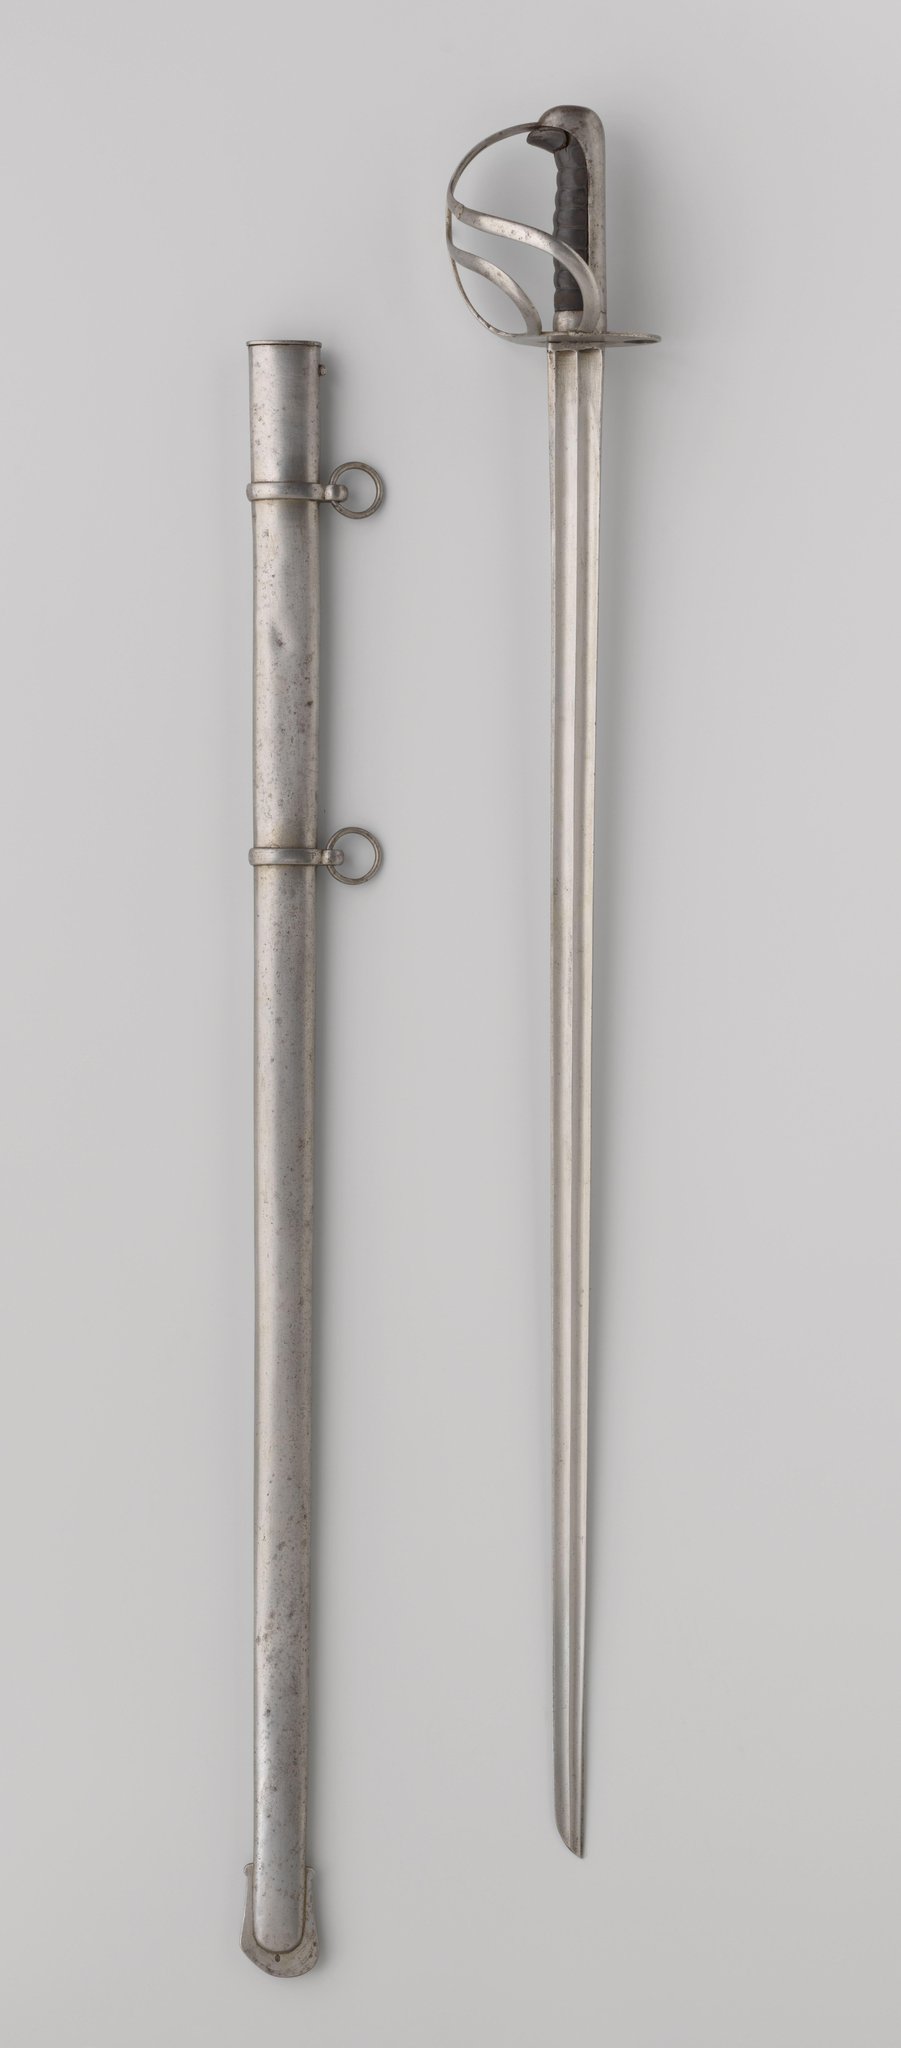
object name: sabre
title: Sabel met schede, cavalerie model nr. 7, dragonders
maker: Anonymous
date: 1844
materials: iron, leather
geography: delft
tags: netherlands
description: Sabel cavalerie model nr. 7 dragonders met schede. Voor karabijn. Met gewoon gevest. Delft.